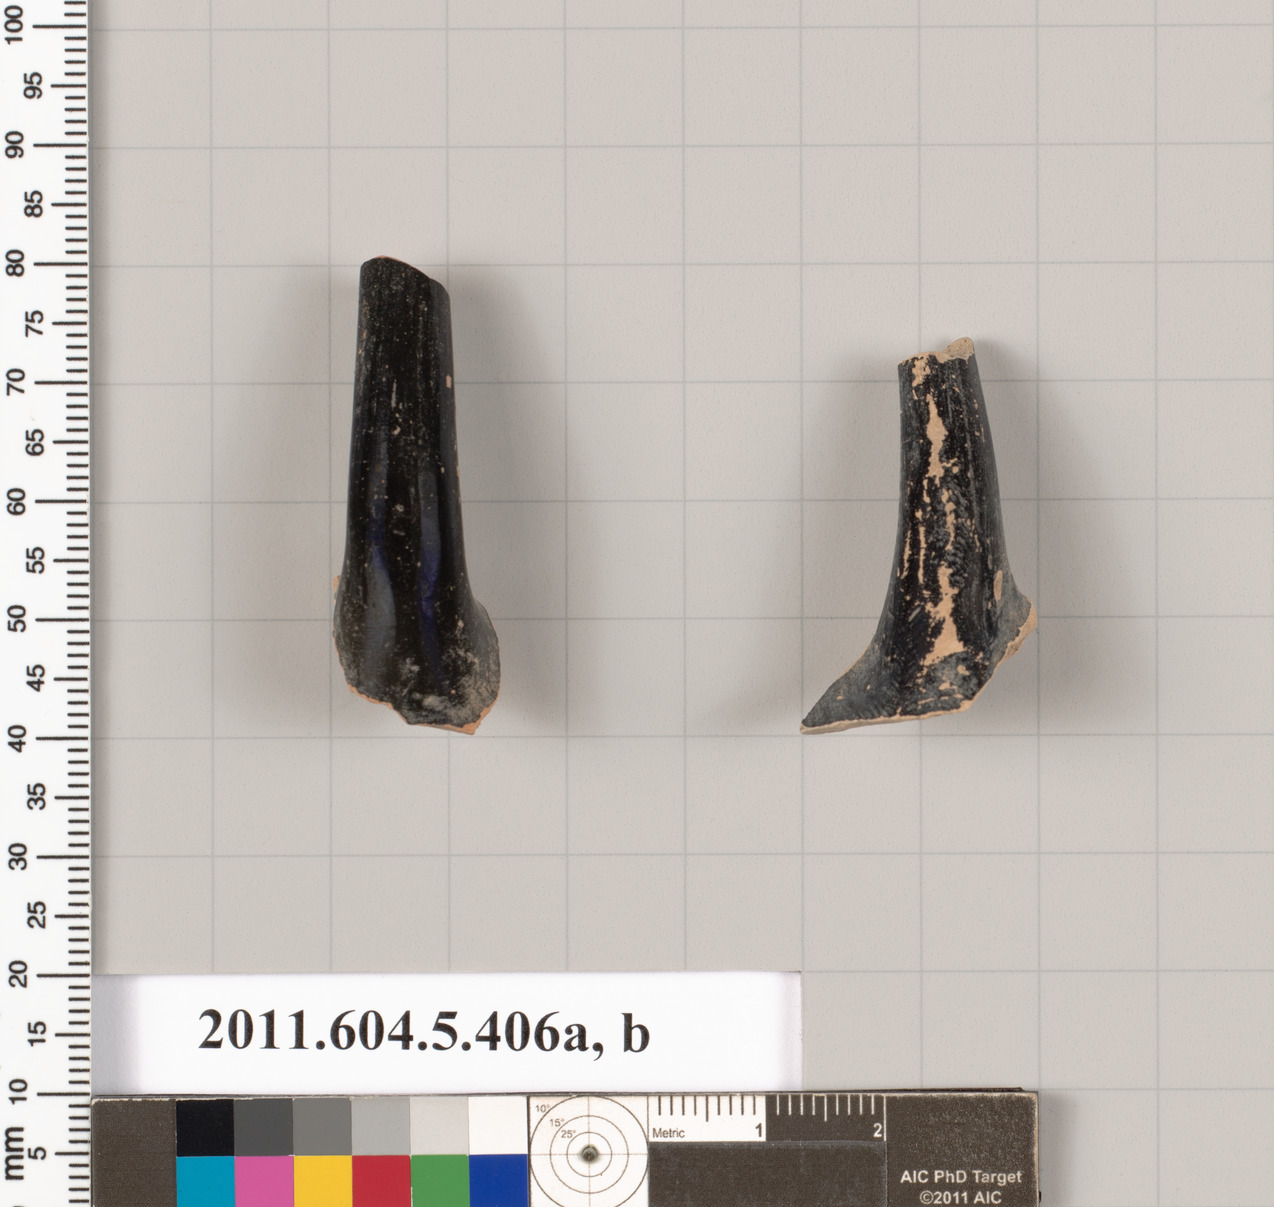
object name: kylix fragment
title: Terracotta fragments of kylikes (drinking cups)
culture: greek, attic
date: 600-401 BCE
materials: terracotta